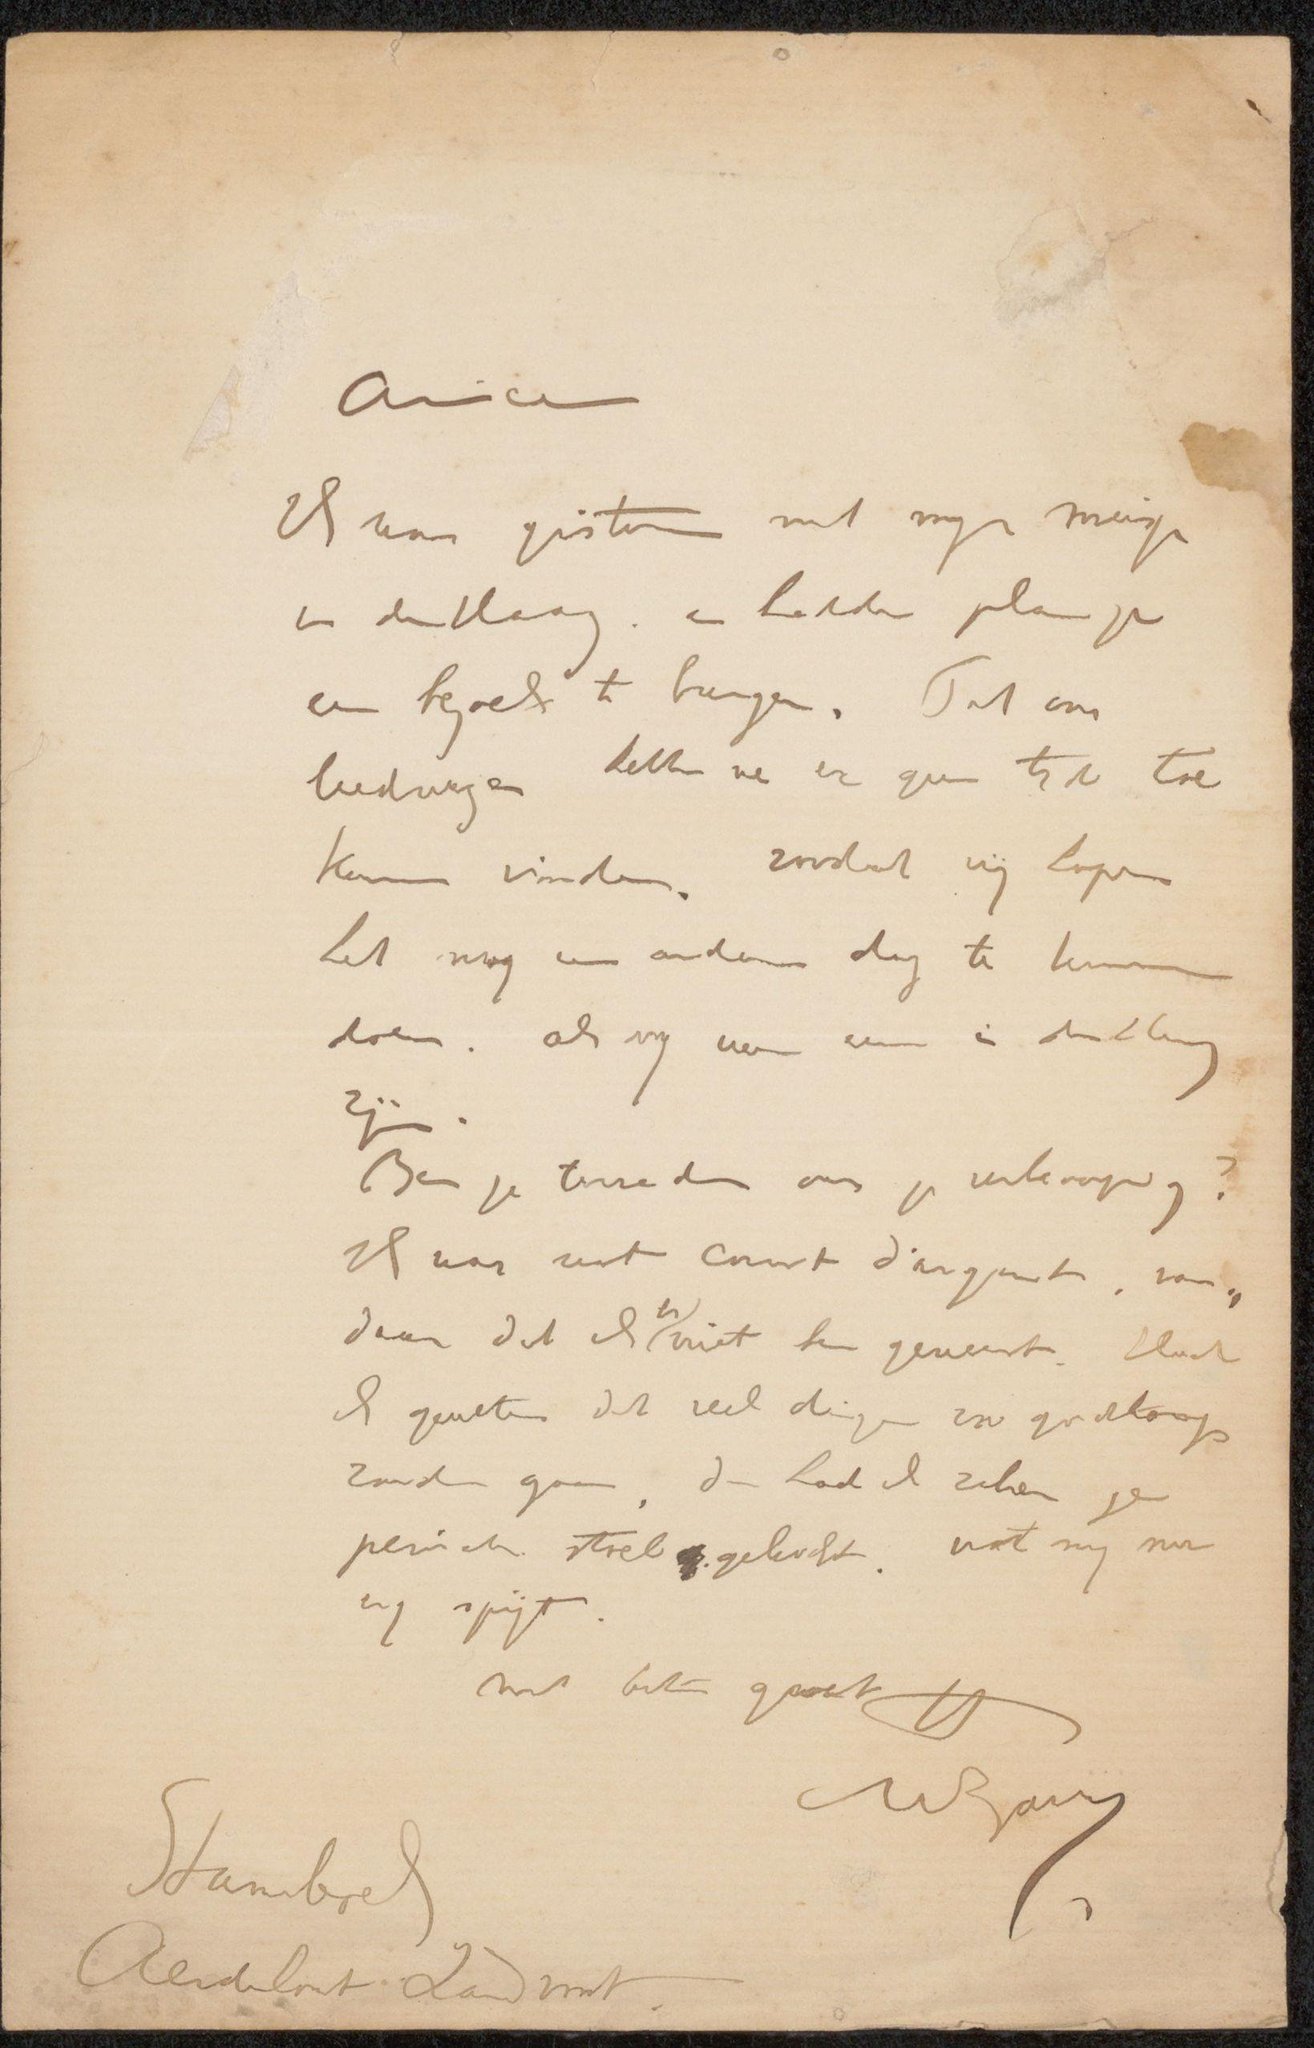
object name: letter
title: Brief aan Philip Zilcken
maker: marius bauer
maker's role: draughtsman, print maker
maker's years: 1867-1932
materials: ink, paper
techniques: pen, writing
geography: aerdenhout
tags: johanna bauer-stumpff, painter, philip zilcken, the hague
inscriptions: collector's mark: ‘RPK’